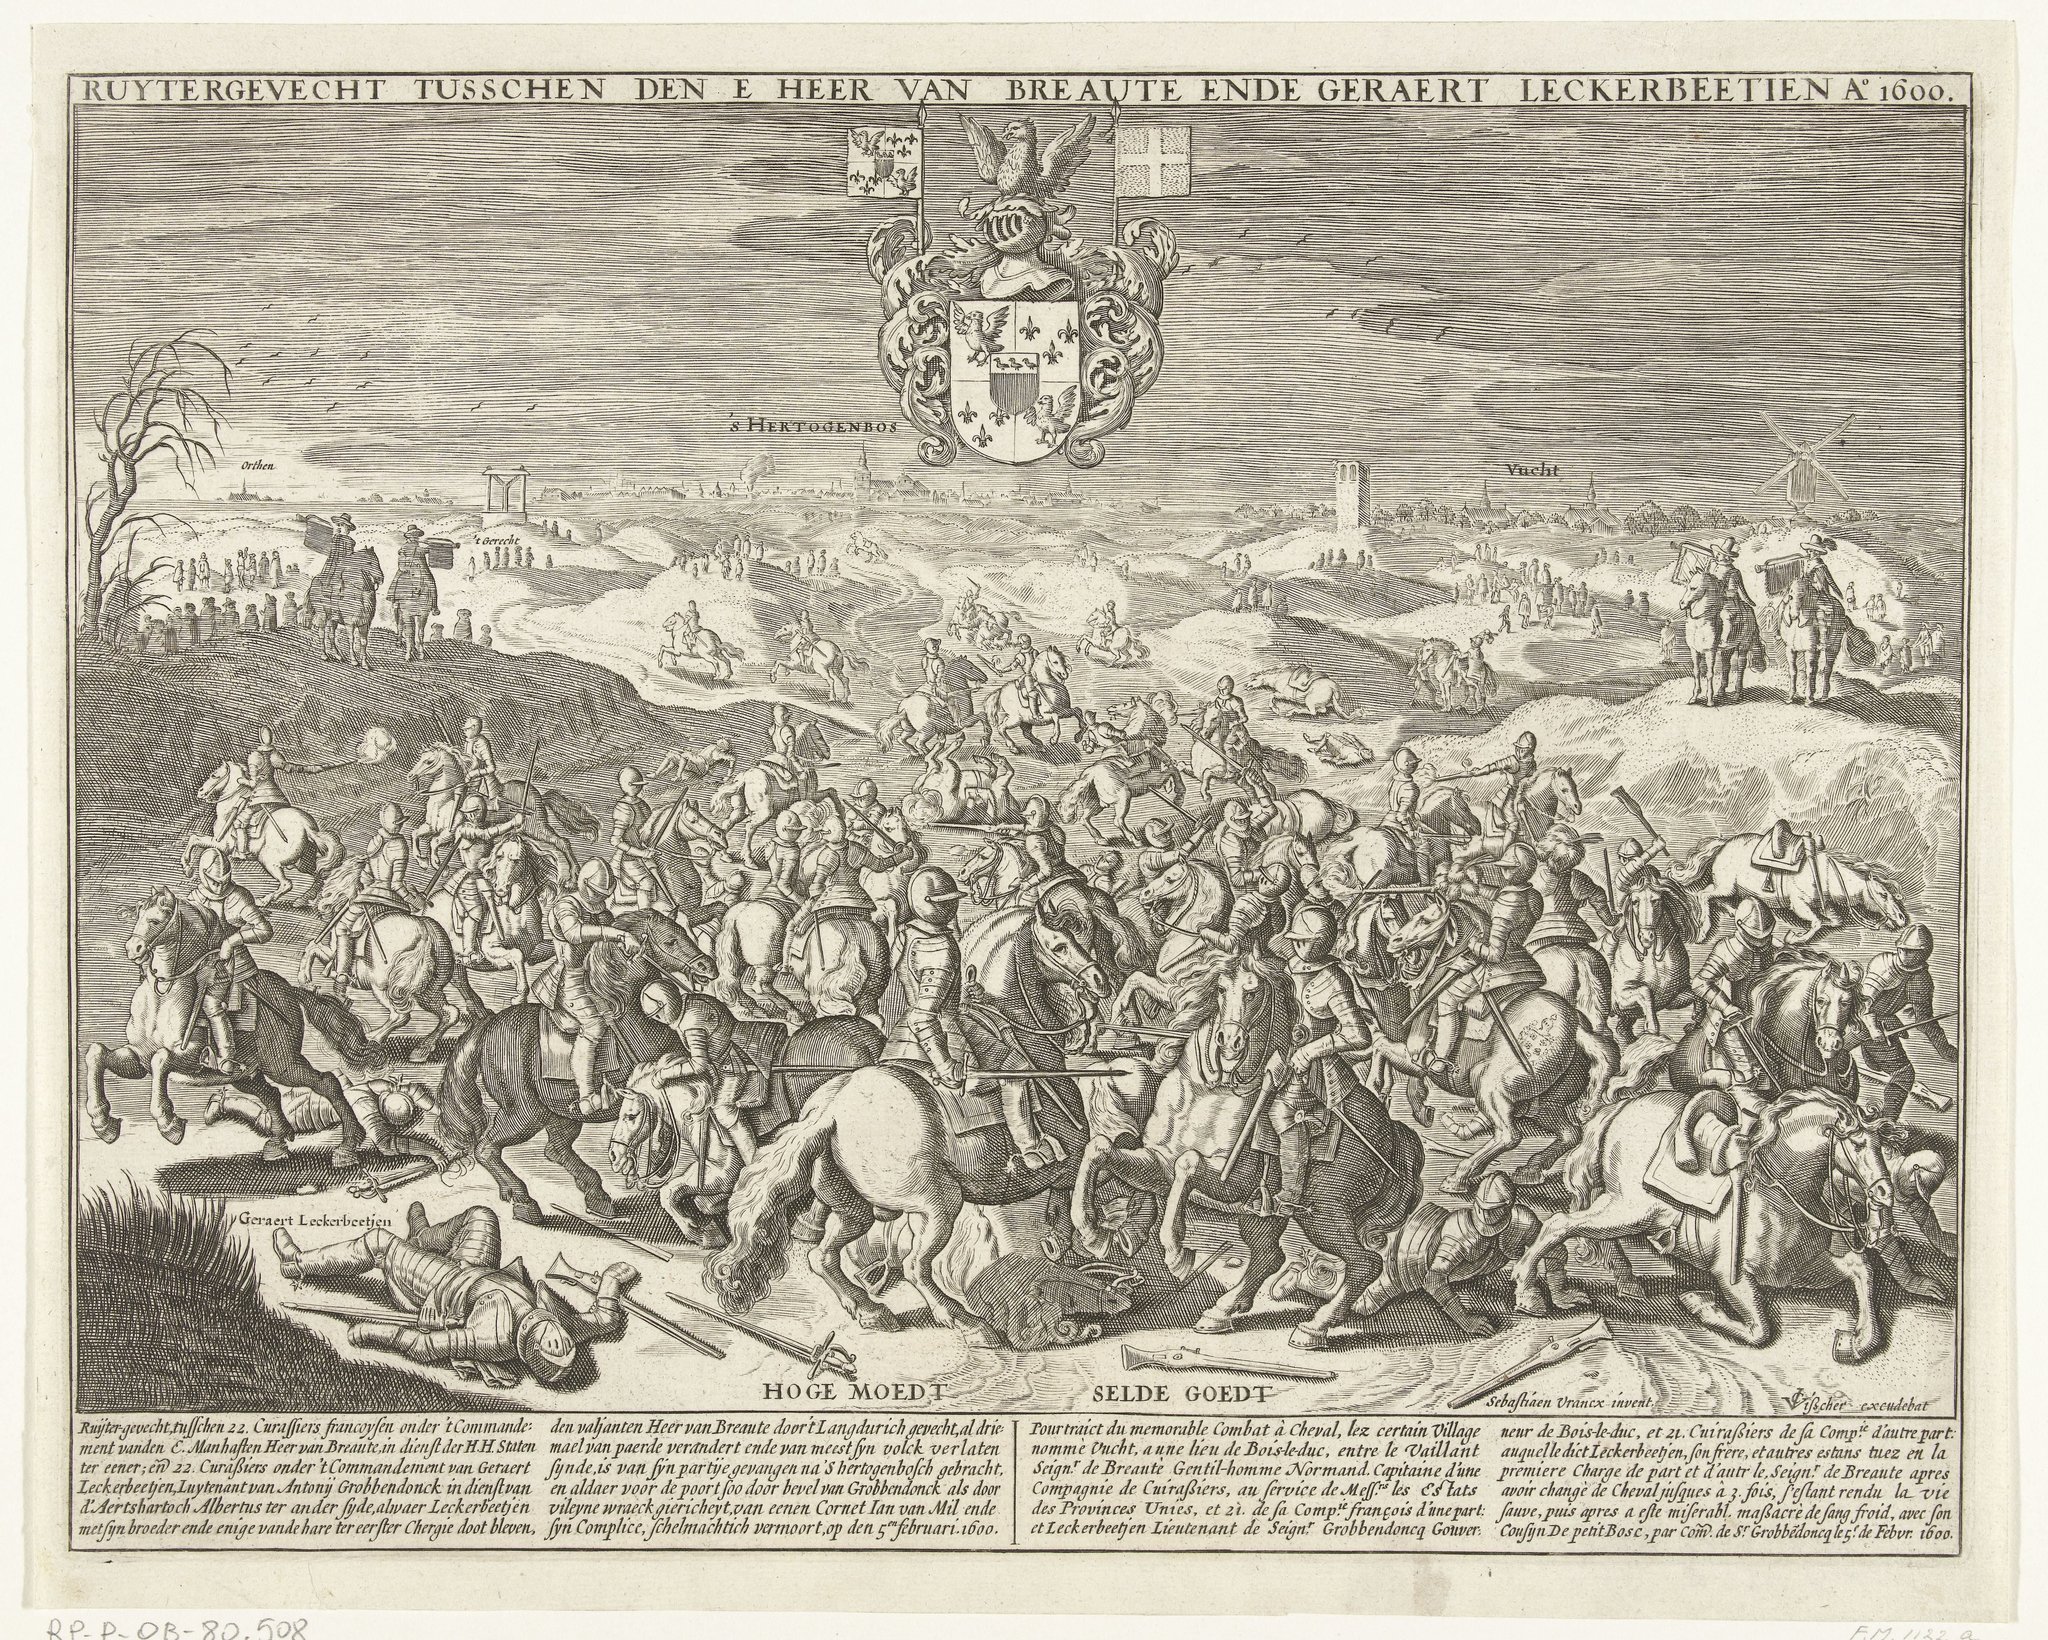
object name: history print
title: Ruytergevecht tusschen den E Heer van Breaute ende Geraert Leckerbeetien Ao. 1600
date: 1630-1650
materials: paper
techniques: engraving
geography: northern netherlands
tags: den bosch, battle (+ land forces)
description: Het gevecht van Lekkerbeetje. Ruitergevecht op de Vughterheide bij Den Bosch tussen de Spaanse ruiters onder Anthony Schetz van Grobbendonck en de Staatse ruiters onder de Pierre de Breauté, 5 februari 1600. Op de voorgrond links ligt de gesneuvelde Gerardt Abrahamsz. Lekkerbeetje. In de verte 's-Hertogenbosch en Vught. Bovenin het wapen van Grobbendonck. Onderaan het opschrift Hoge Moedt Selde Goedt. Met onderschrift van 2 kolommen in het Nederlands en 2 kolommen in het Frans.